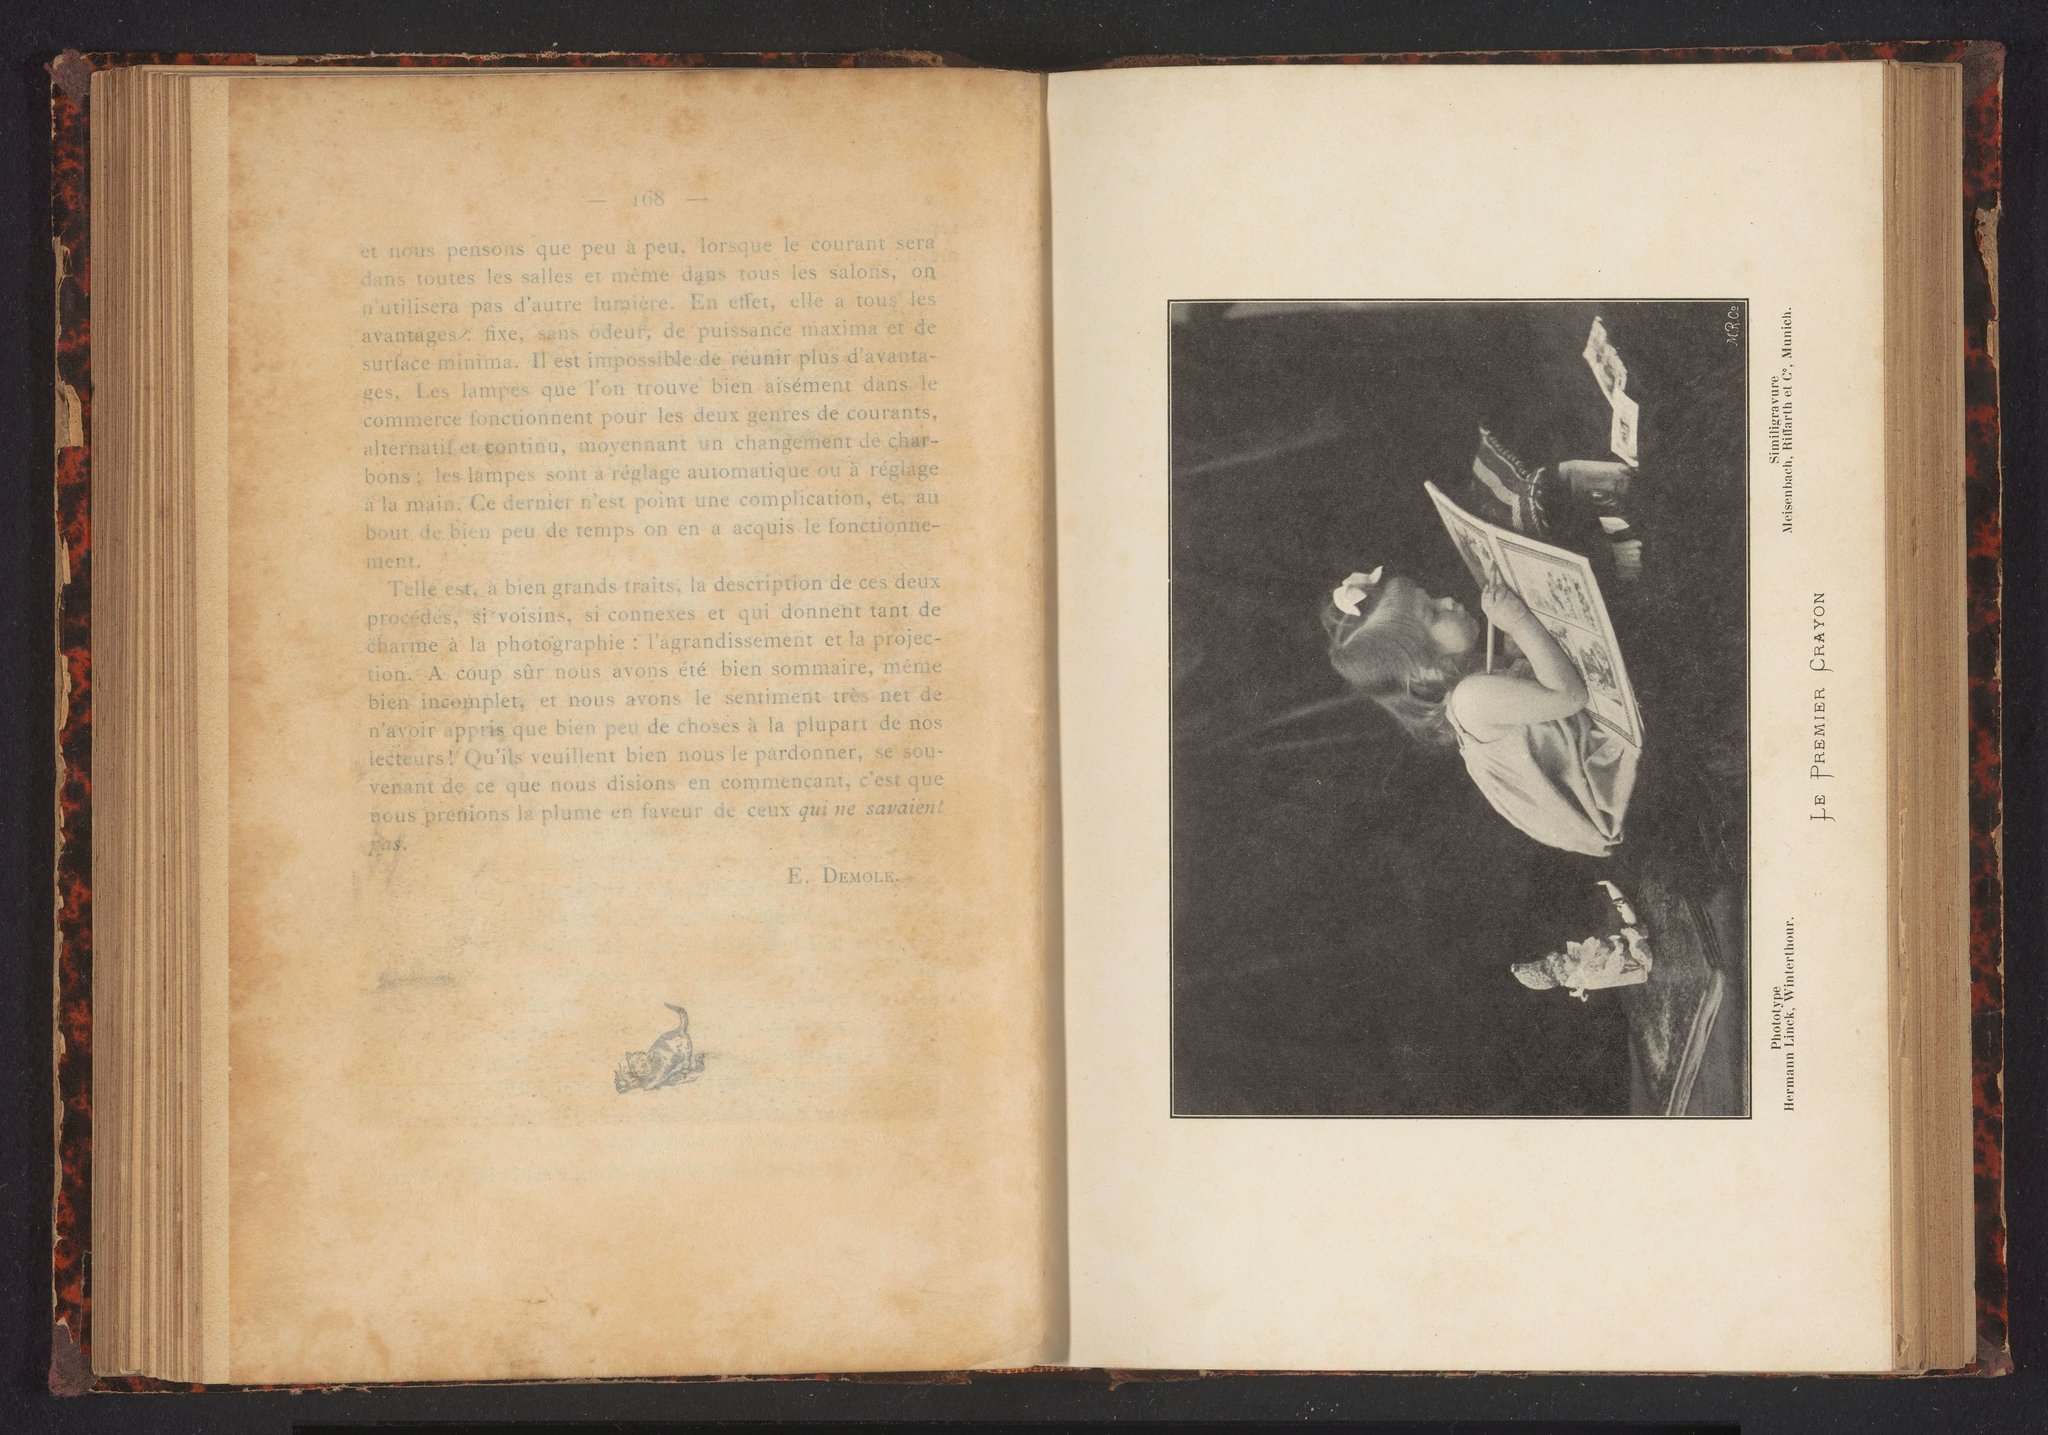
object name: page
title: Portret van een onbekend meisje met een kleurplaat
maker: hermann linck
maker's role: fotograaf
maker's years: 1866-1938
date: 1895-1900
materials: paper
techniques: autotype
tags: drawing, historical persons - bb - woman, girl (child between toddler and youth)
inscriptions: monogram: ‘M.R.Co’